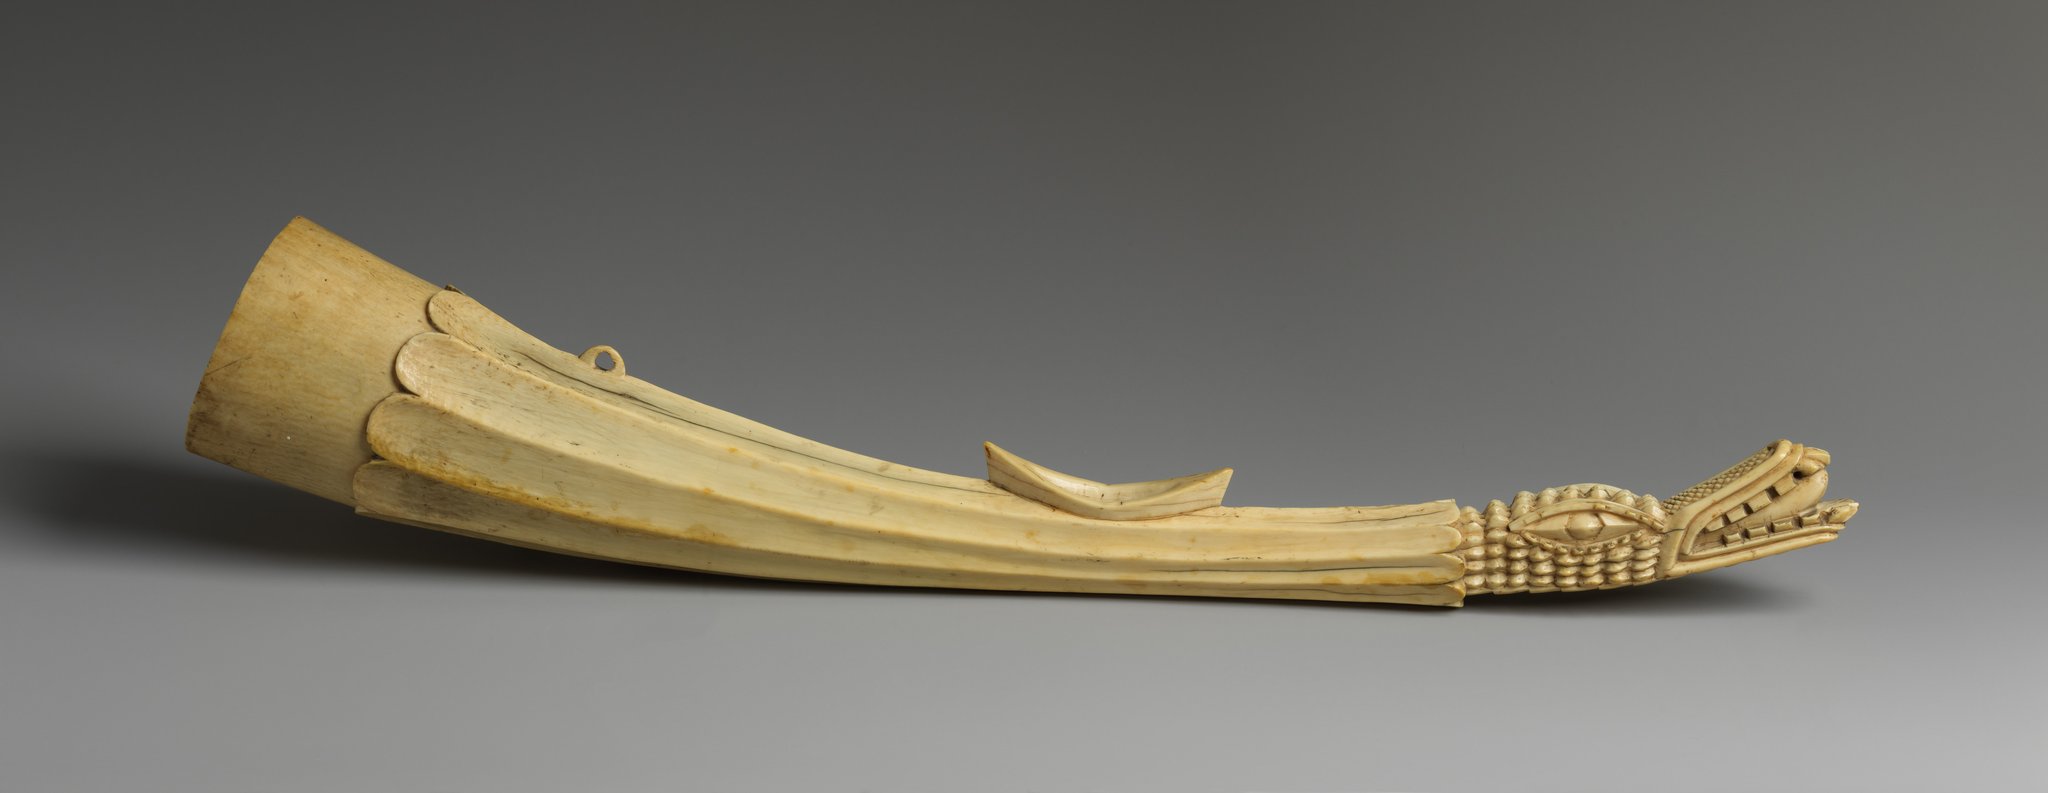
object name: horn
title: Oliphant (side-blown horn)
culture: bullom or temne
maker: temne or bullom artist(s)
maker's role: artist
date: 1490-1530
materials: ivory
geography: sierra leone